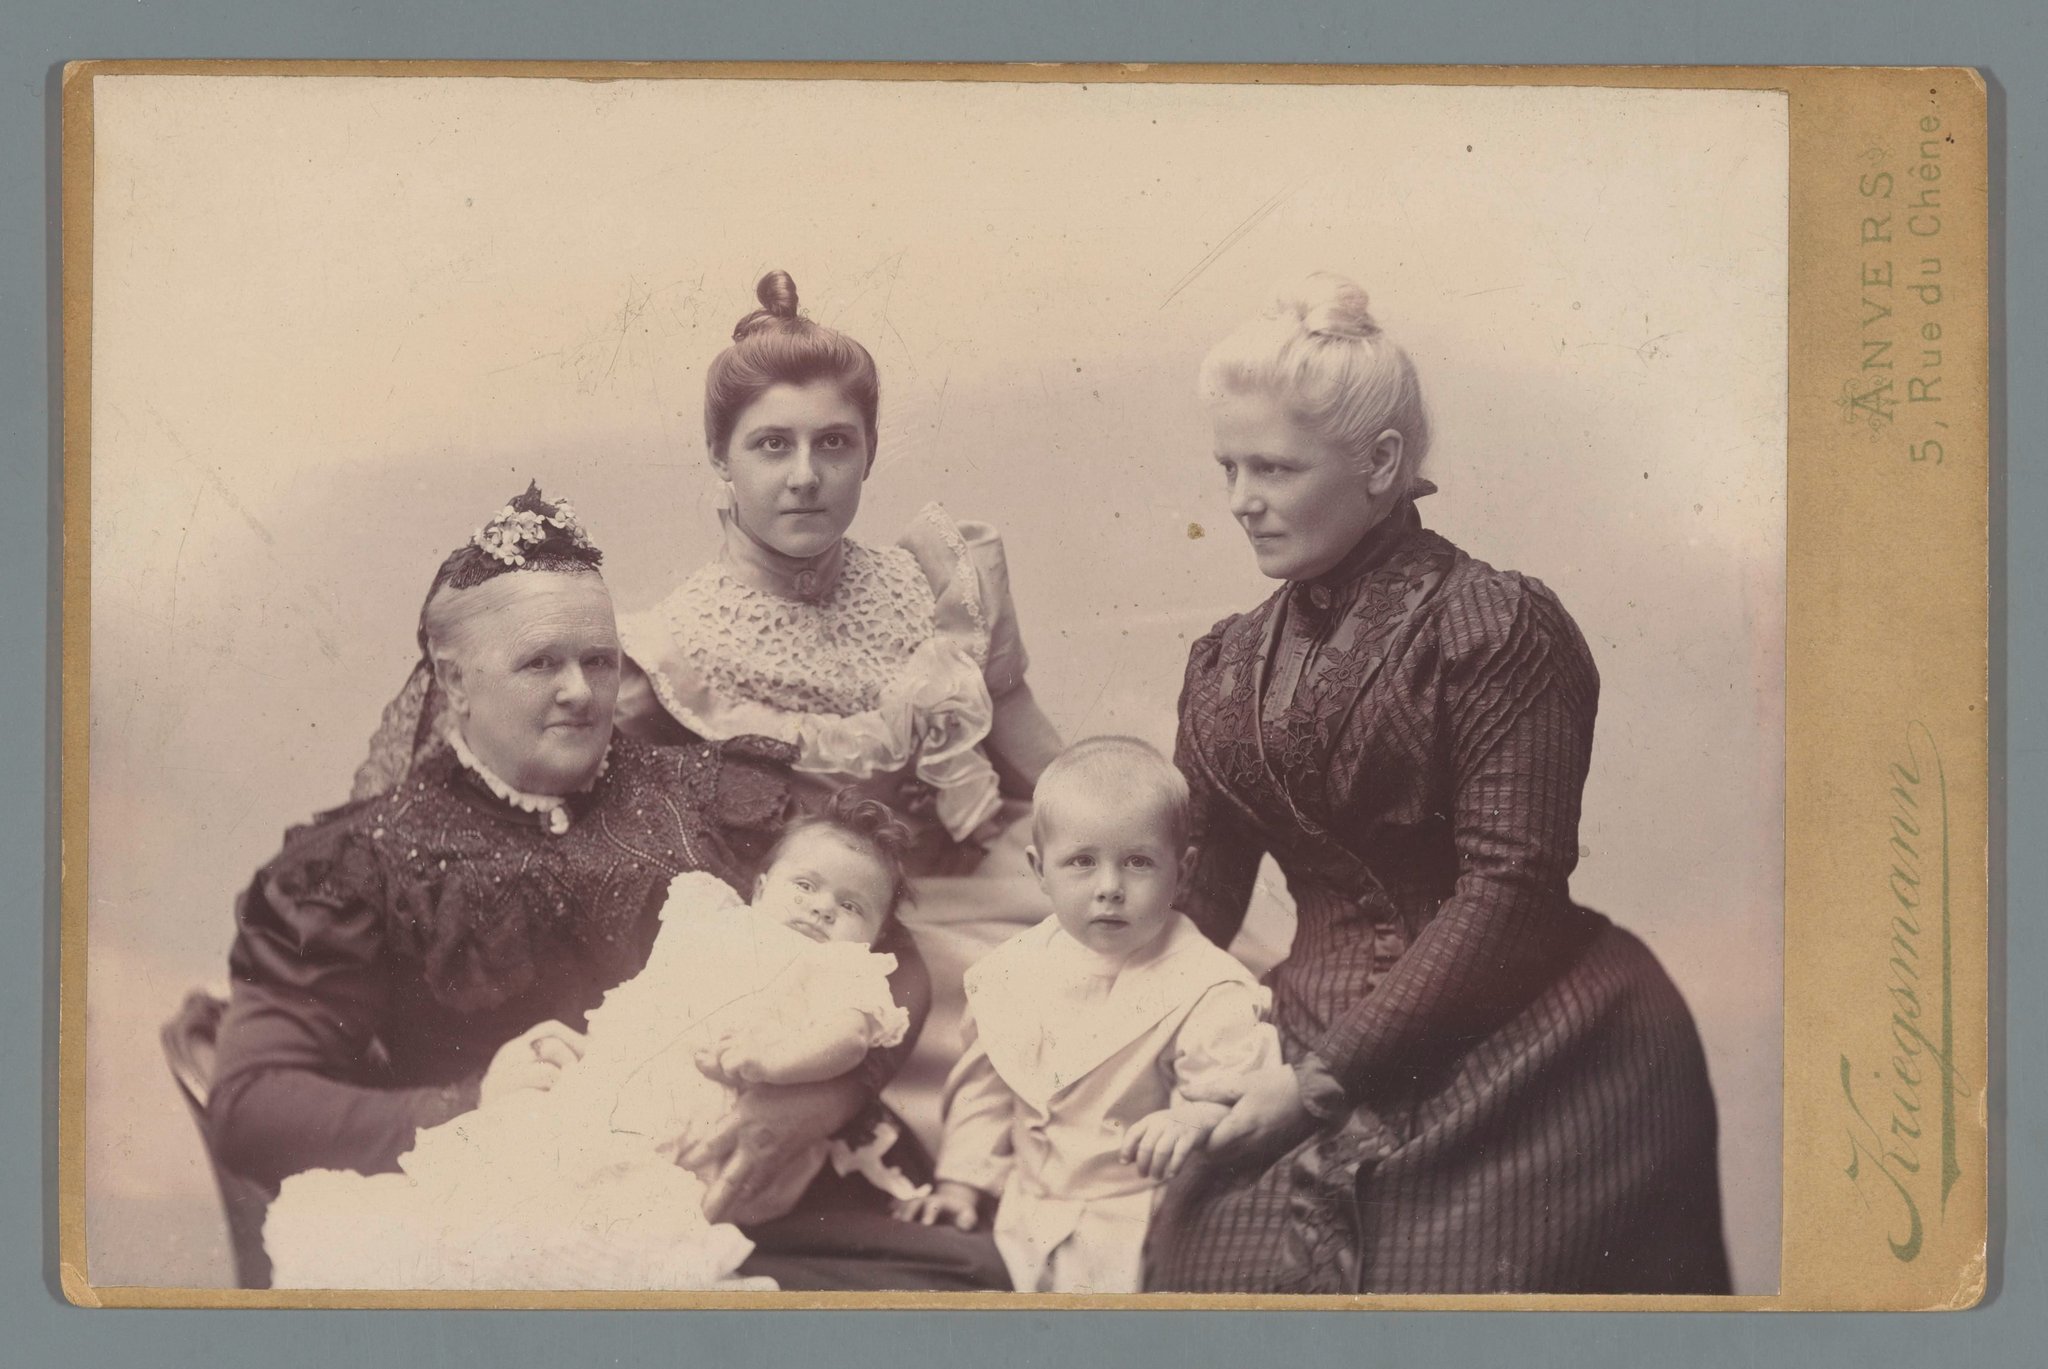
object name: cabinet photograph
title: Groepsportret van drie vrouwen en twee kinderen, vermoedelijk familie van elkaar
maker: m. kriegsmann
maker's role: fotograaf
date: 1890-1910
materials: cardboard, photographic support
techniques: daylight paper print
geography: antwerp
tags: family, relationship, descent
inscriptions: name: ‘Kriegsmann Anvers 5, Rue du Chêne (..)’, name: ‘[...] Hernan’